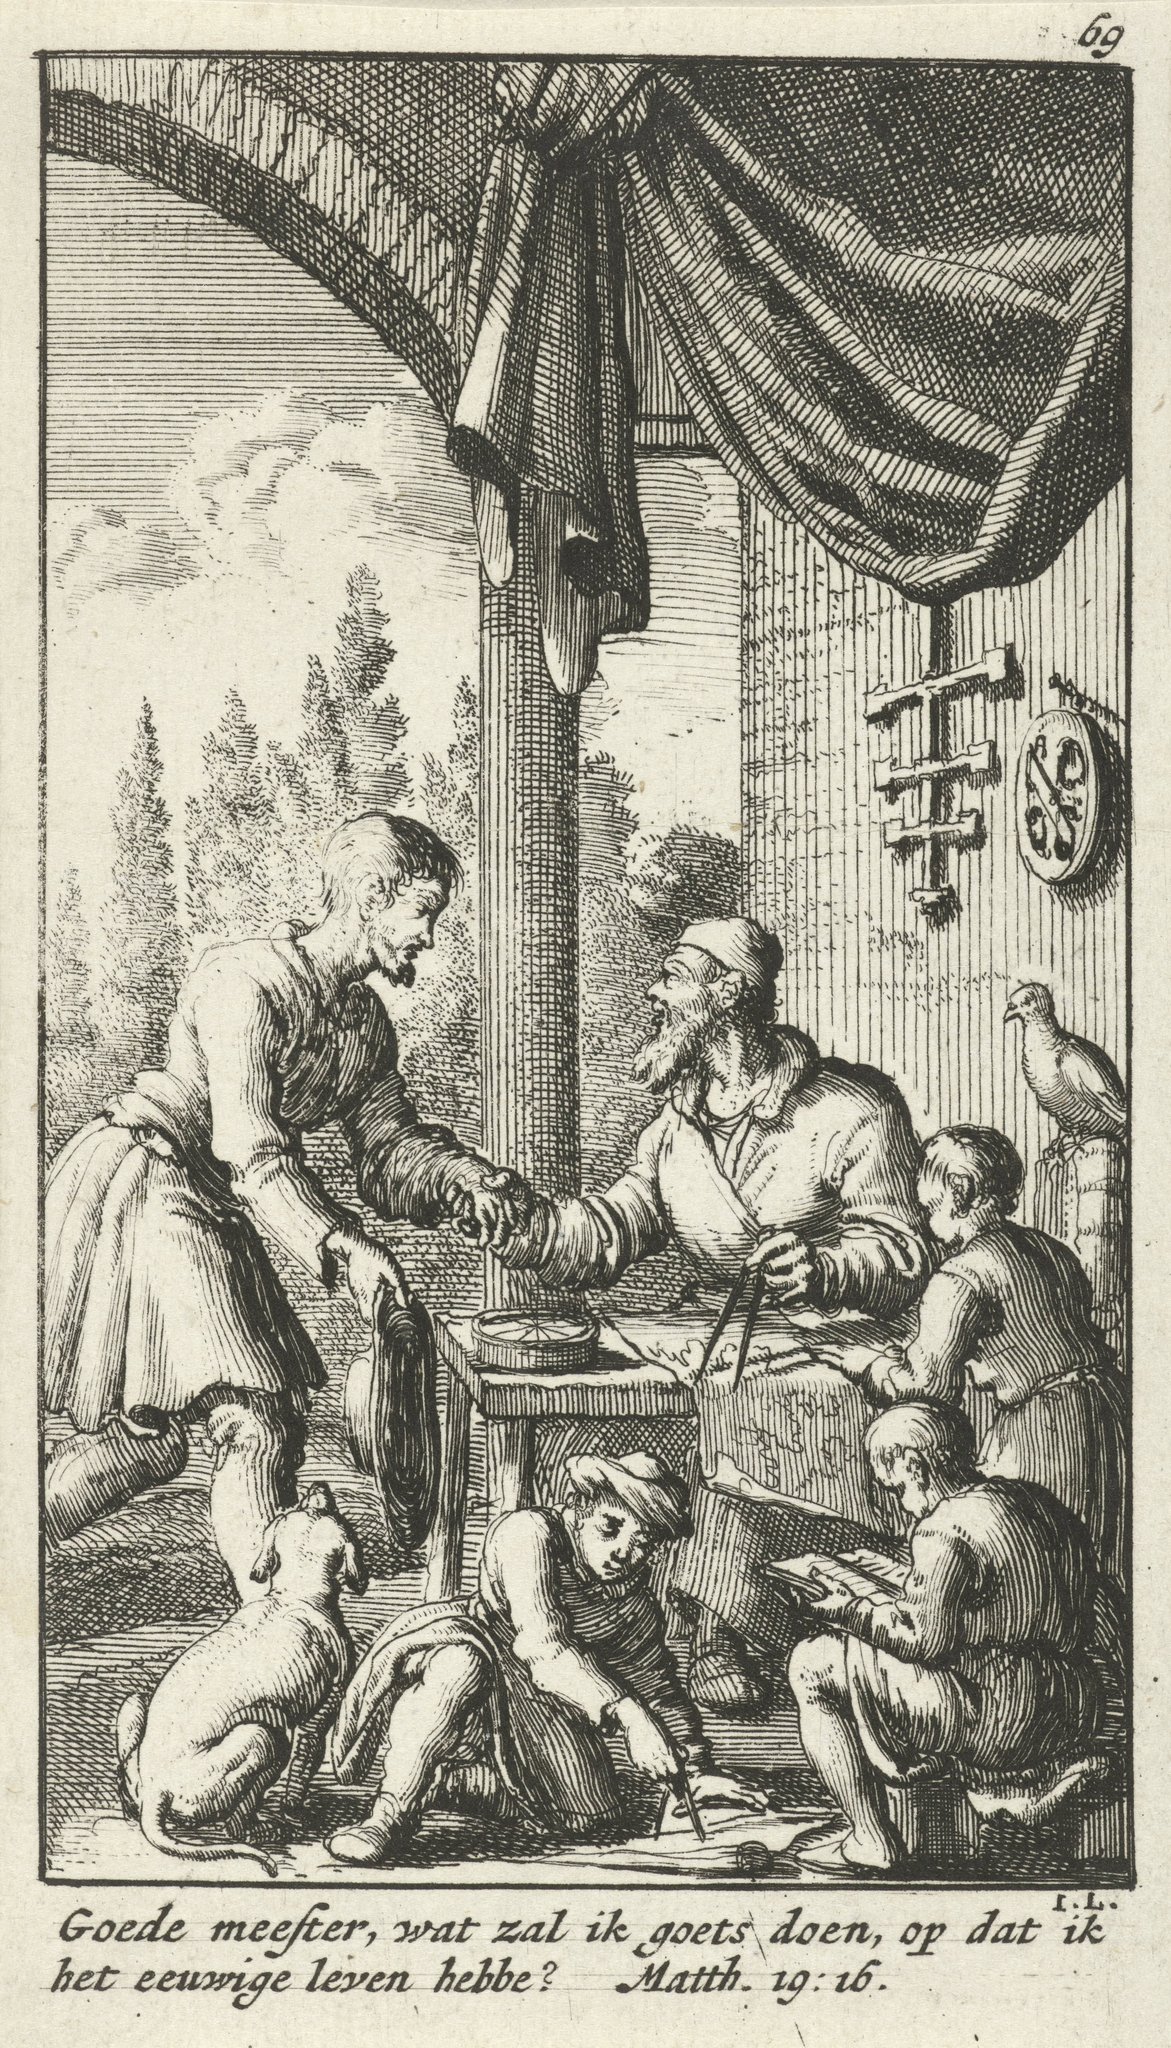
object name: print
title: Man bezoekt een grijsaard die drie jongens onderwijst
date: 1683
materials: paper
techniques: etching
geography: amsterdam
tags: teacher and pupil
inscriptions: collector's mark: Lugt 240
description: Illustratie opgenomen in: Dircksz, Jacob (Oom). Een alegoris-historis verhaal van het edel en machtig koninkrĳk van Salem. Amsterdam: Jan Rieuwertsz (I), 1683.